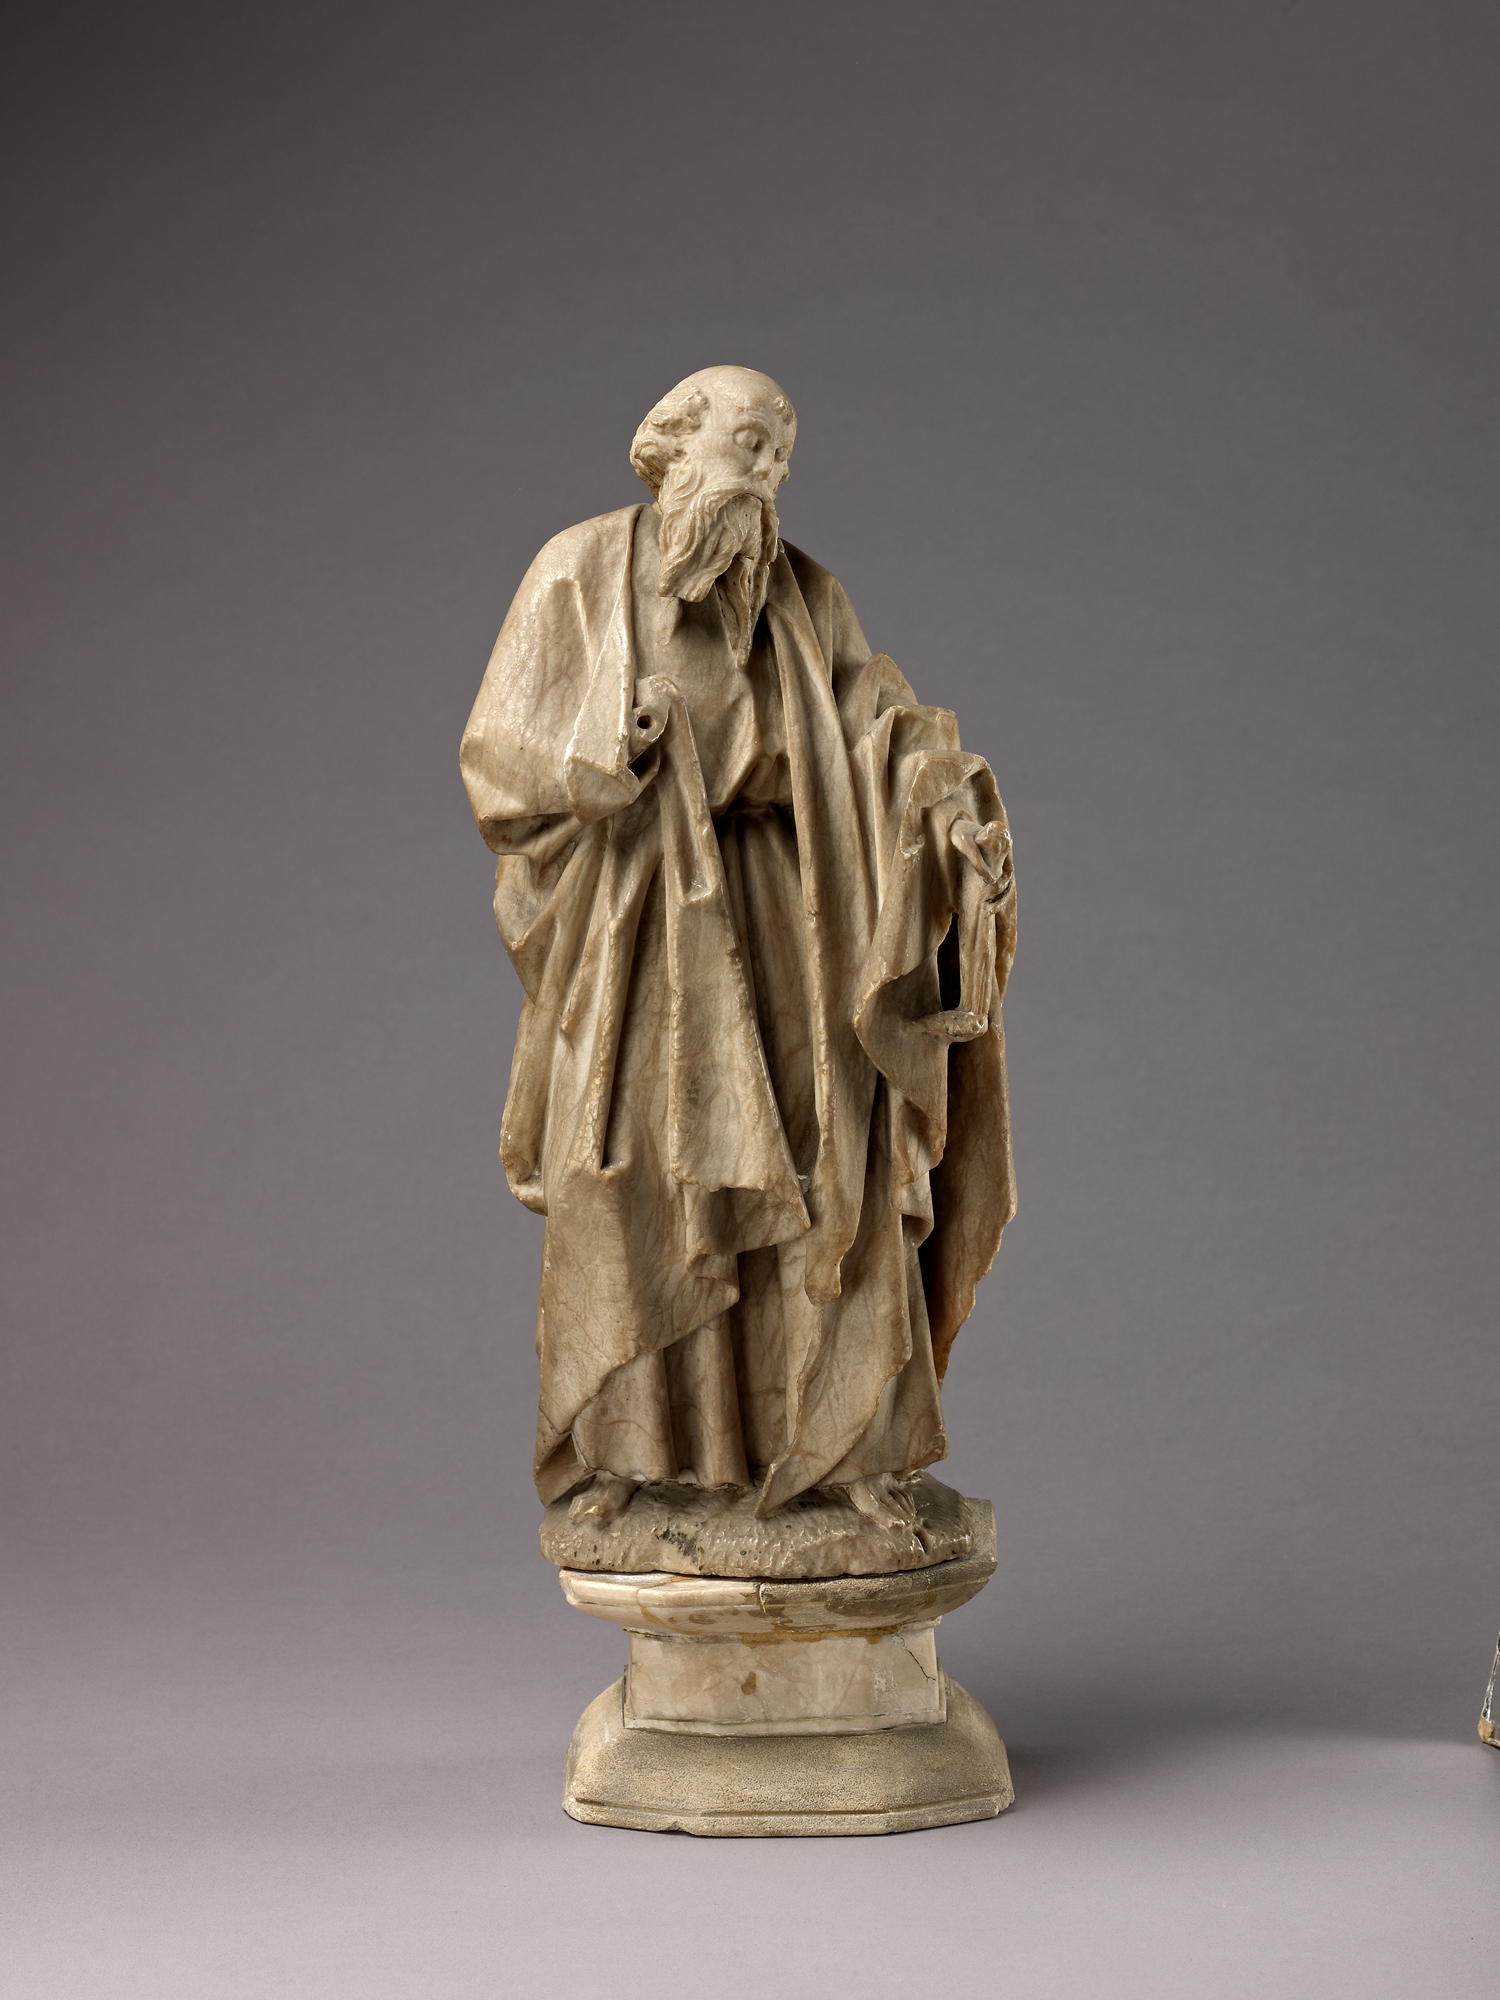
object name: statue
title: Saint Paul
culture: northern french or southern netherlandish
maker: southern netherlands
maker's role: artist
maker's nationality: southern netherlands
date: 1450-1470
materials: alabaster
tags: saint paul